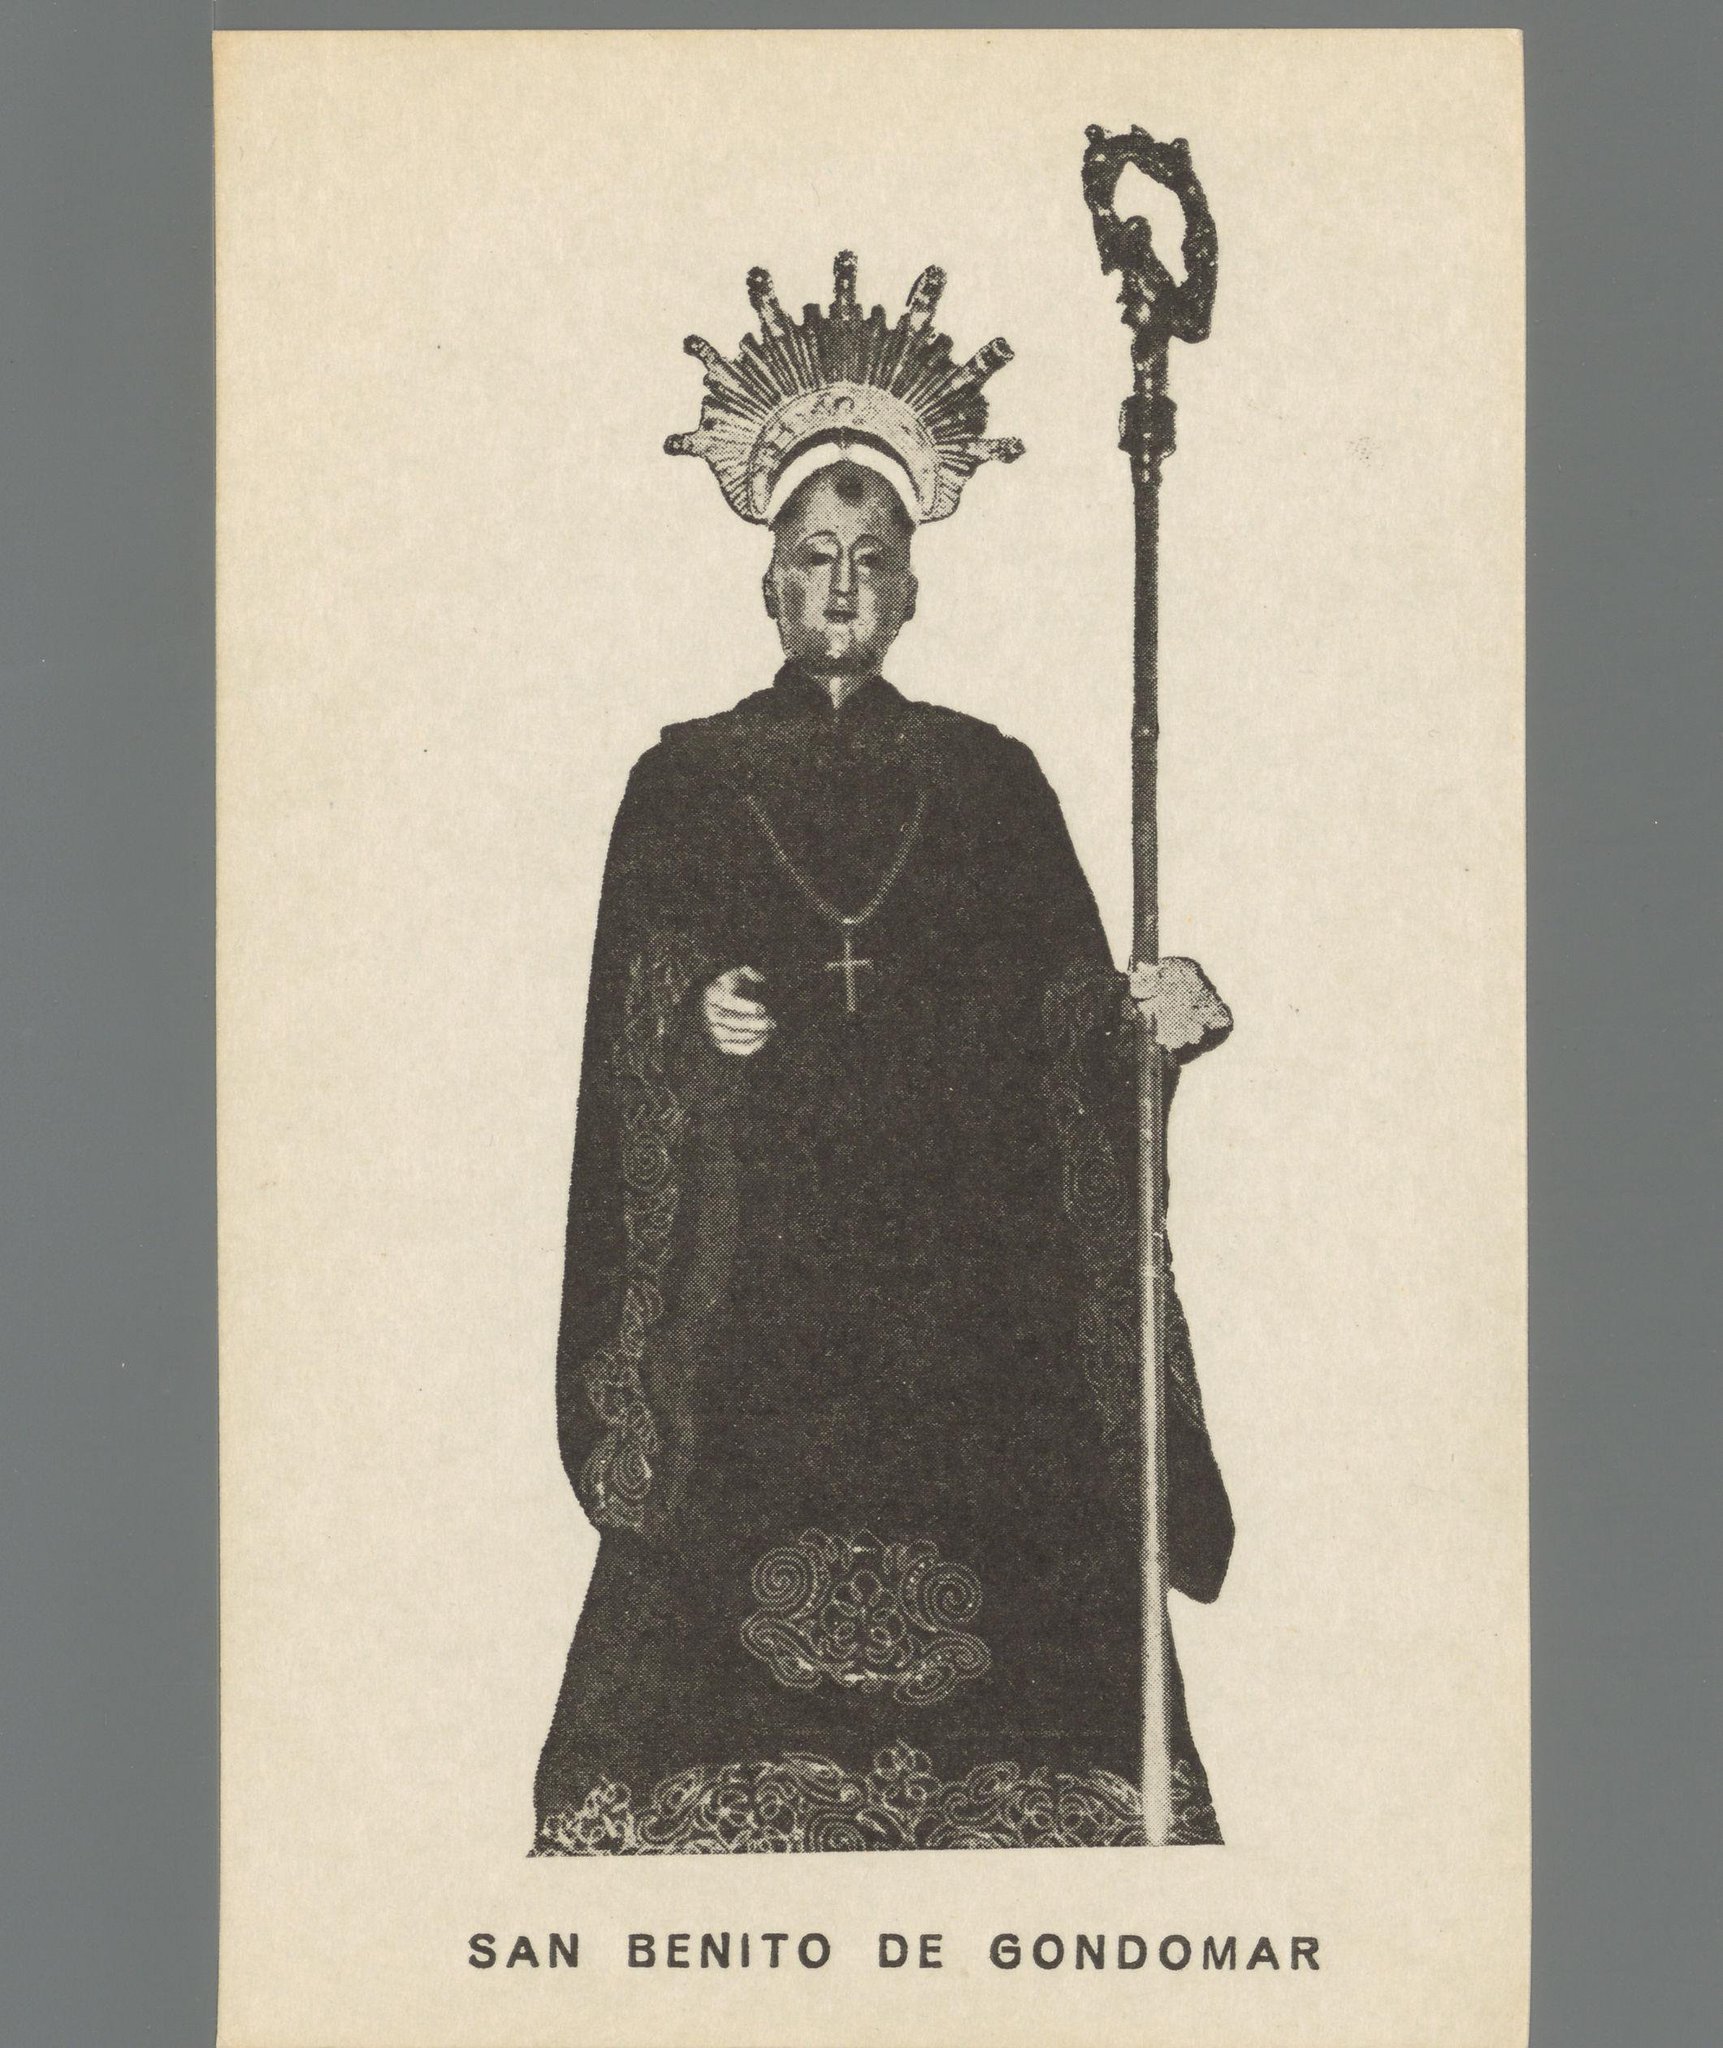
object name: photomechanical print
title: San Benito de Gondomar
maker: Anonymous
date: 1945-1965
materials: cardboard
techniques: autotype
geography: gondomar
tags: saints, interior of church, sculpture